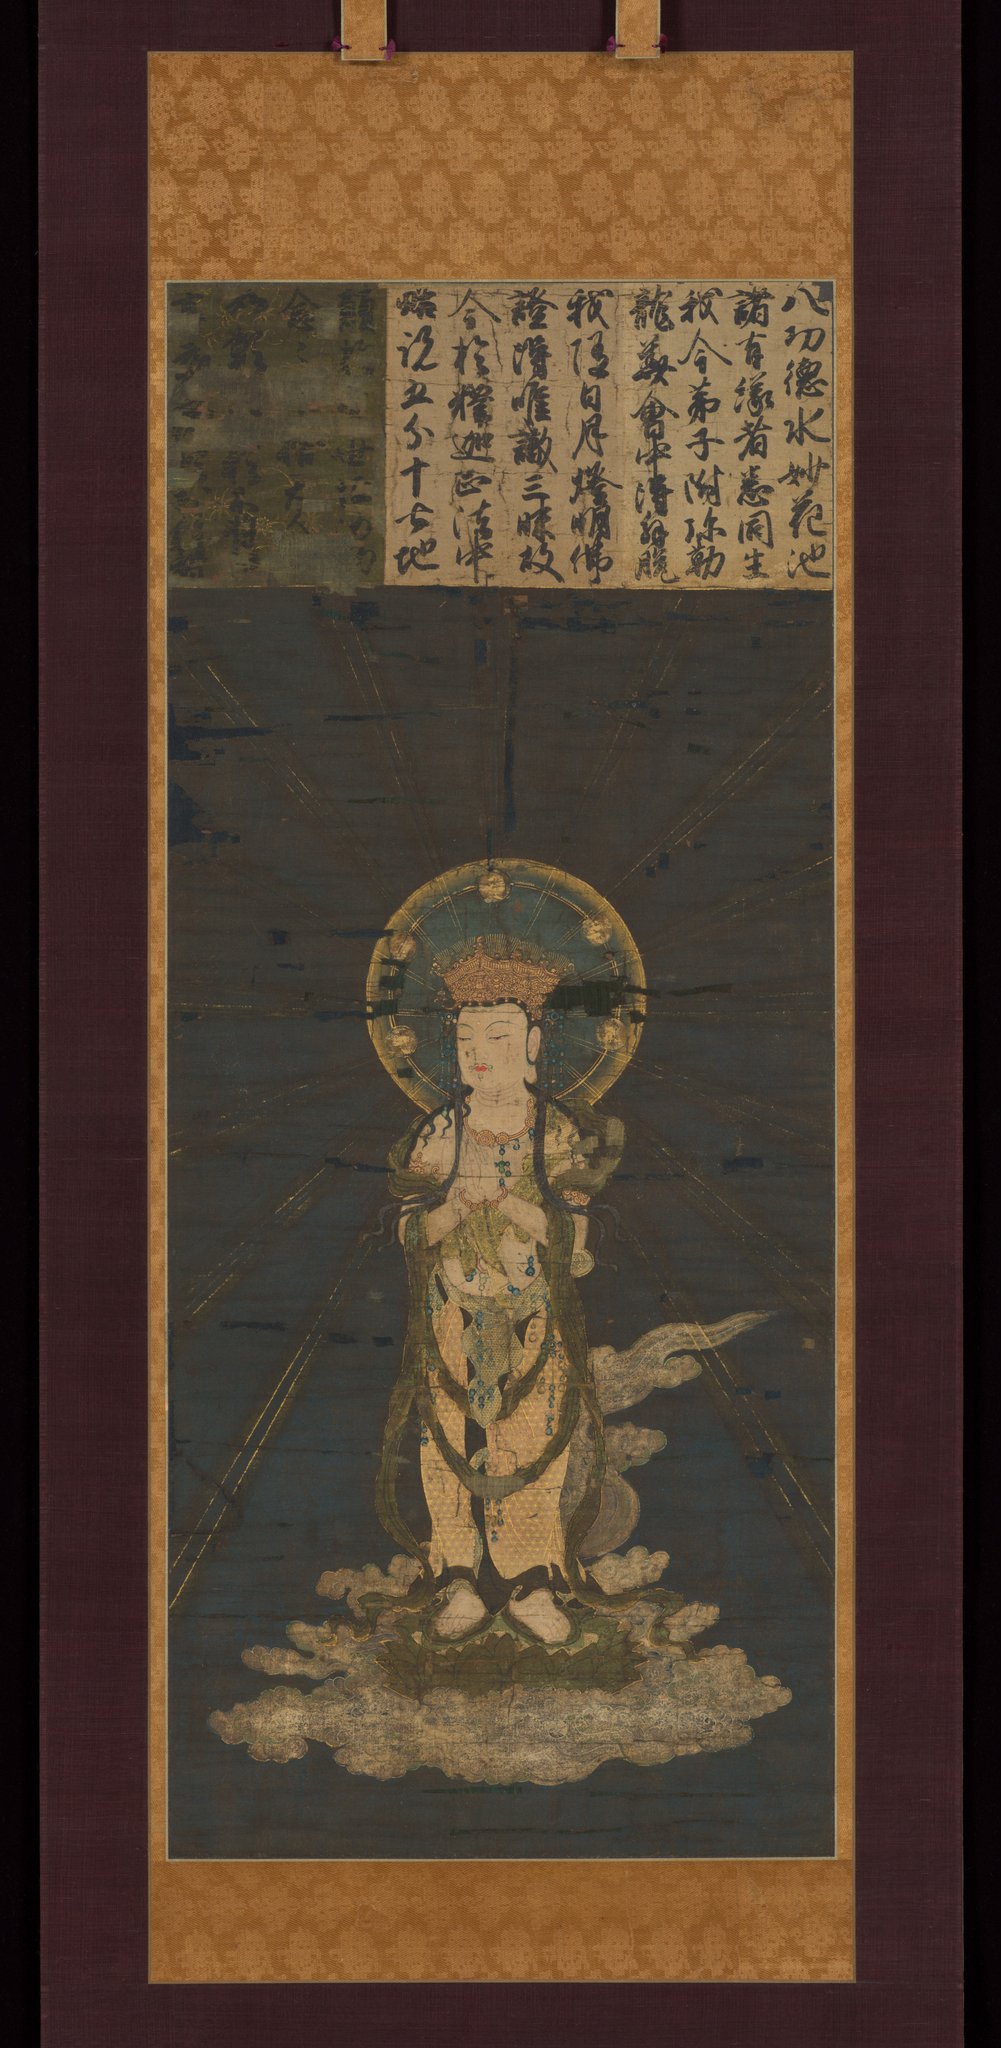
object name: hanging scroll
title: Miroku Bosatsu (Bodhisattva Maitreya) in Welcoming Descent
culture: japanese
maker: unidentified artist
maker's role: artist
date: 1301-1333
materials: gold, gold leaf, ink, silk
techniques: cutting, kirikane